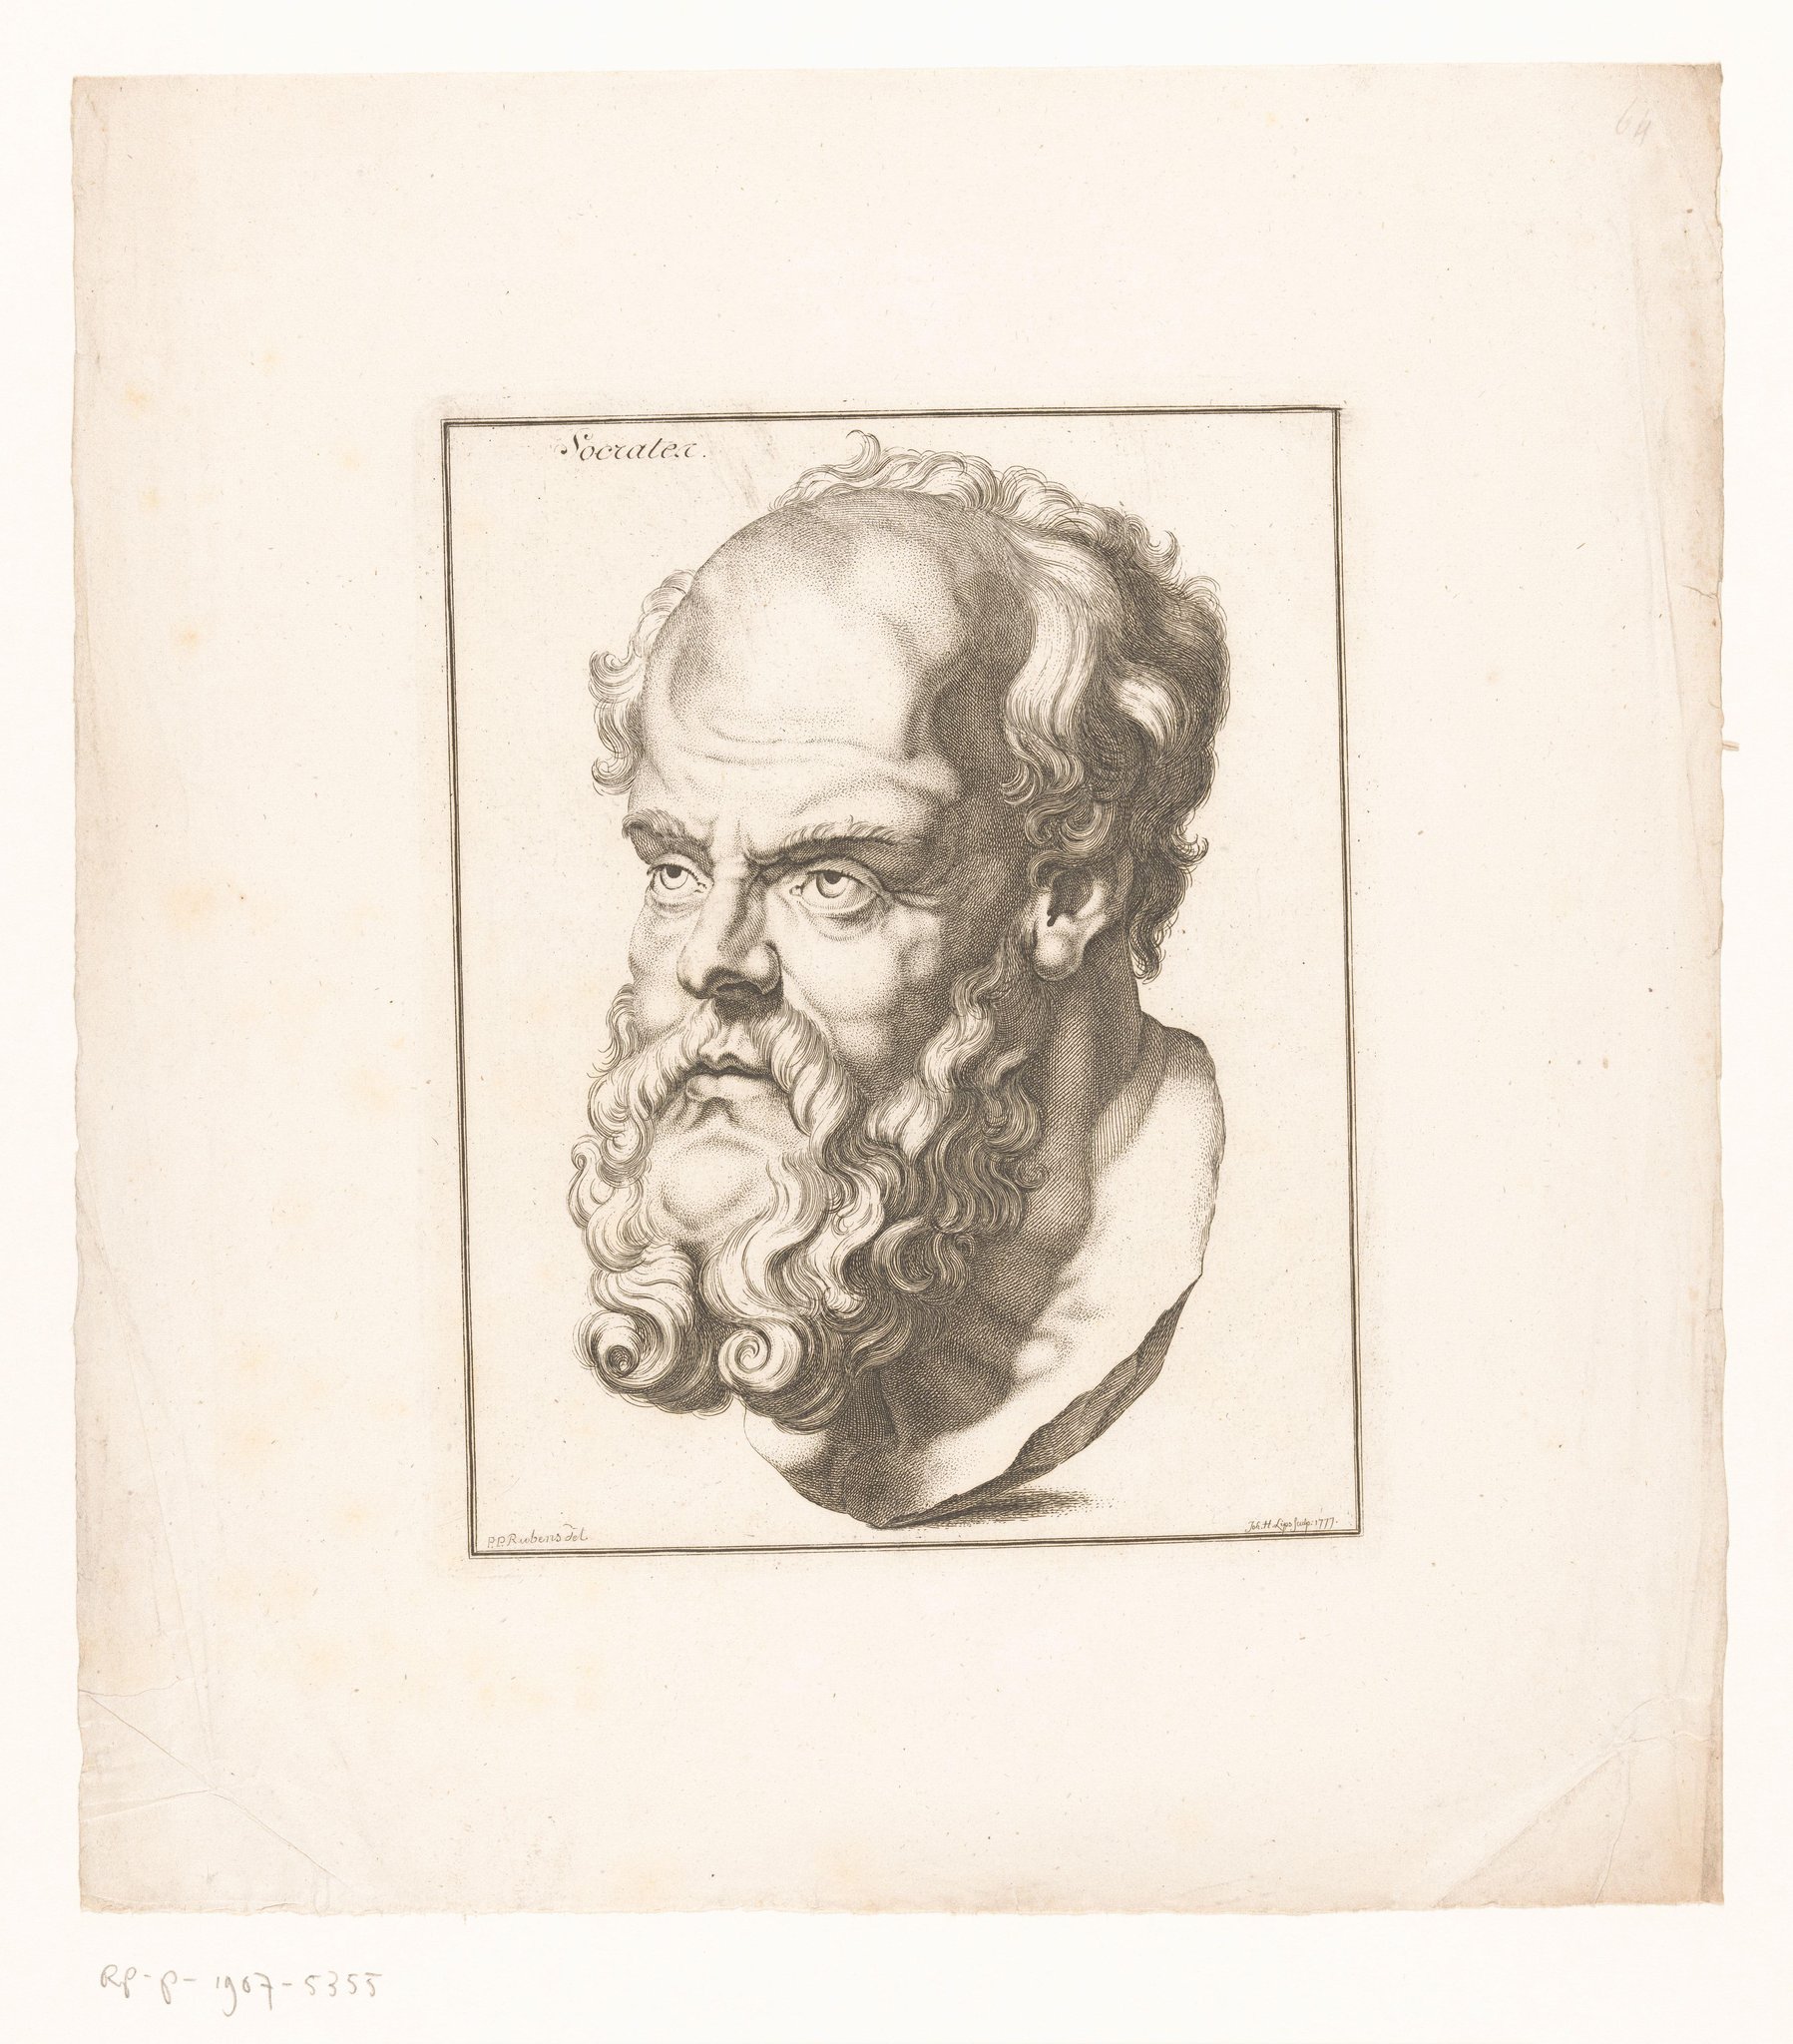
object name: print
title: Portret van Socrates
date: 1777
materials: paper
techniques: engraving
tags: scholar, philosopher, historical persons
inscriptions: collector's mark: Lugt 2228